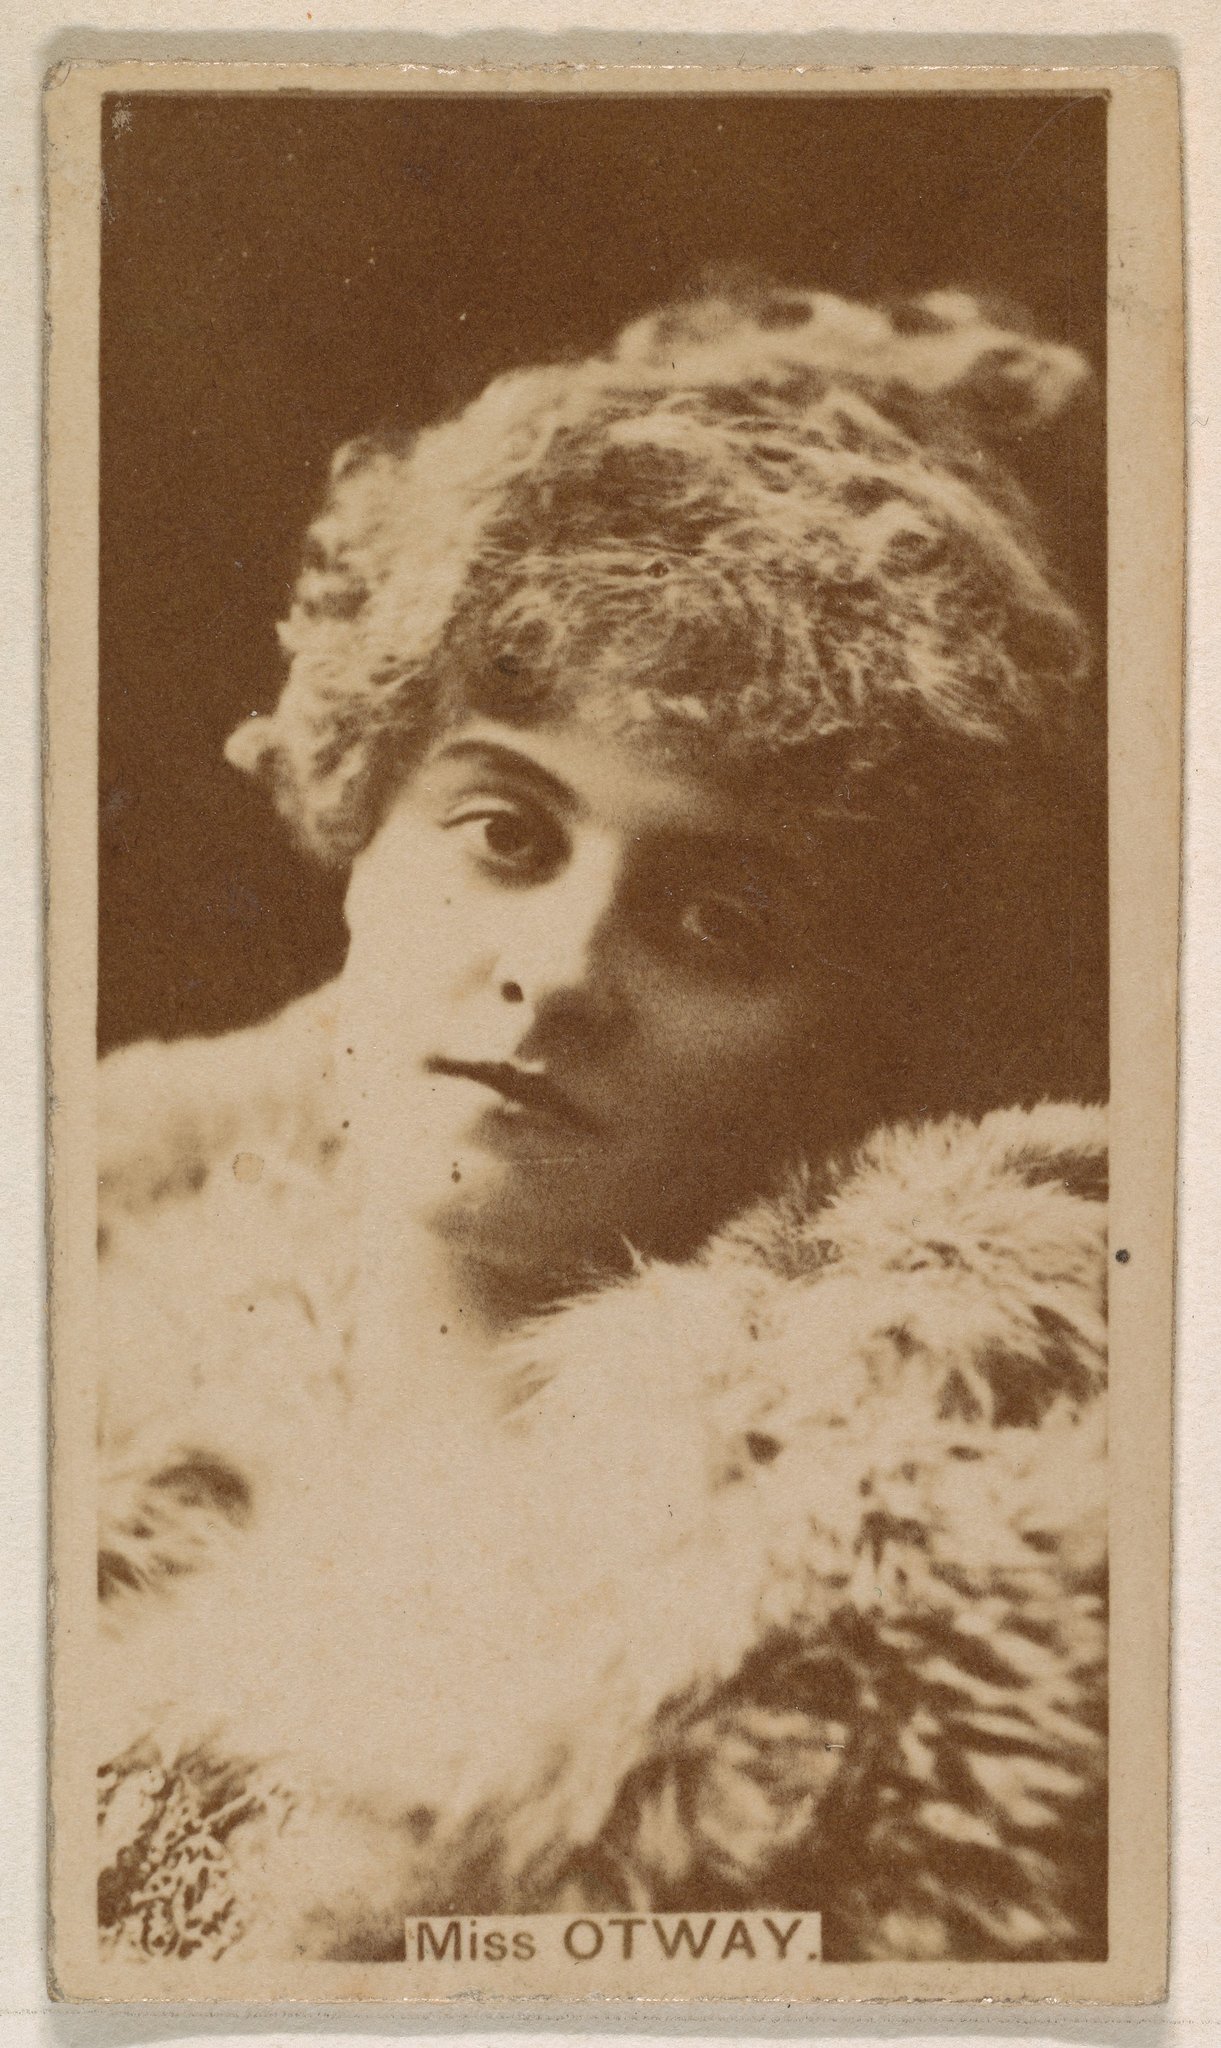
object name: photograph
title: Miss Otway, from the Actresses series (N245) issued by Kinney Brothers to promote Sweet Caporal Cigarettes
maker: kinney brothers tobacco company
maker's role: publisher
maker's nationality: american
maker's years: 1869-2011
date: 1890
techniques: albumen silver print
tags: portraits,women,actresses